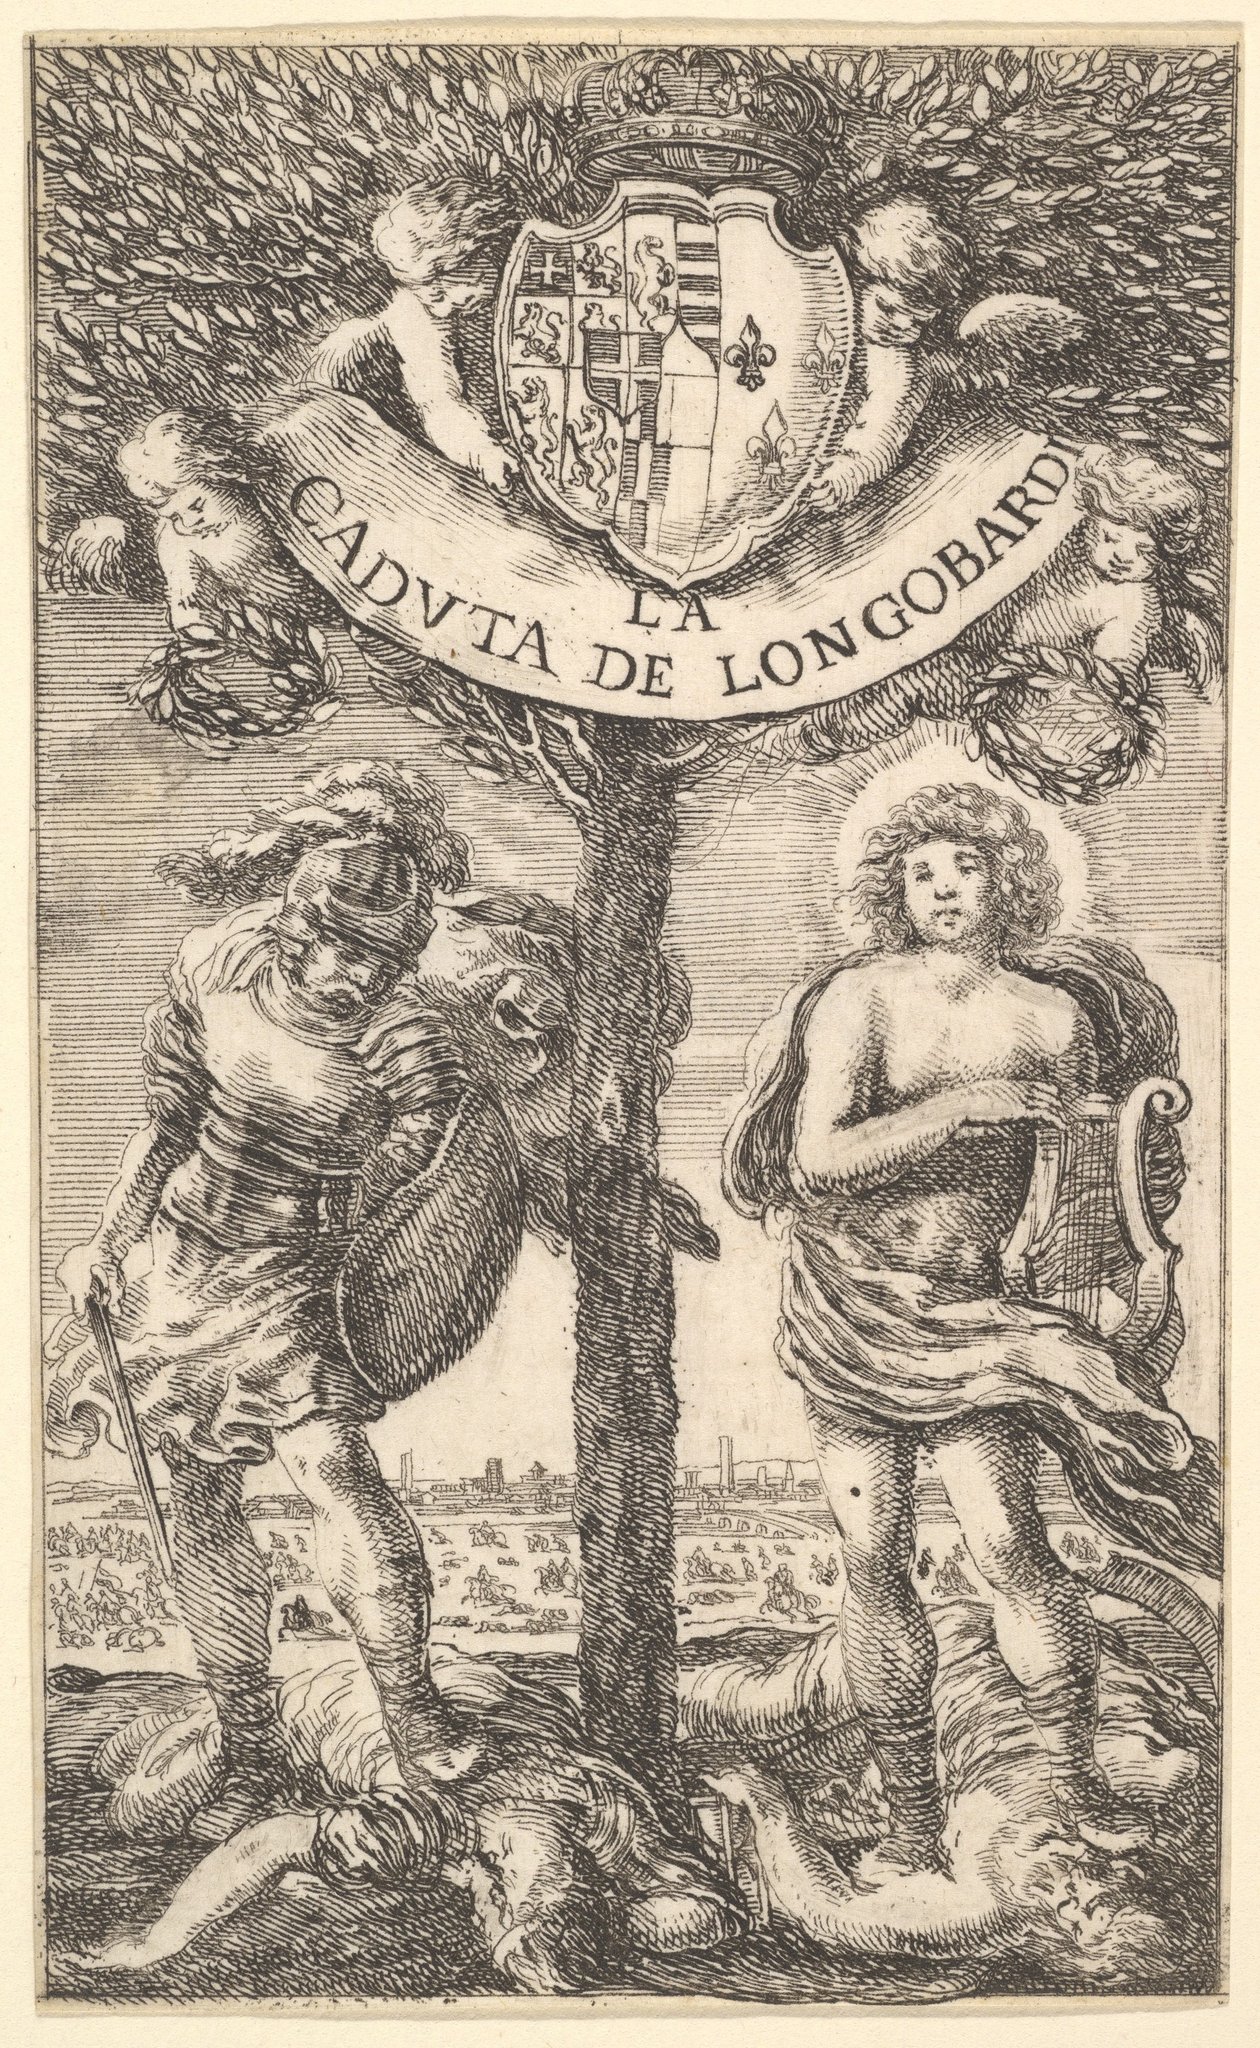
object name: print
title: Frontispiece for "The Fall of Longobardi" (La Caduta de' Longobardi)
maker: stefano della bella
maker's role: artist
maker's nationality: italian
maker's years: 1610-1664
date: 1656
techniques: etching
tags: apollo,putti,mars,coat of arms